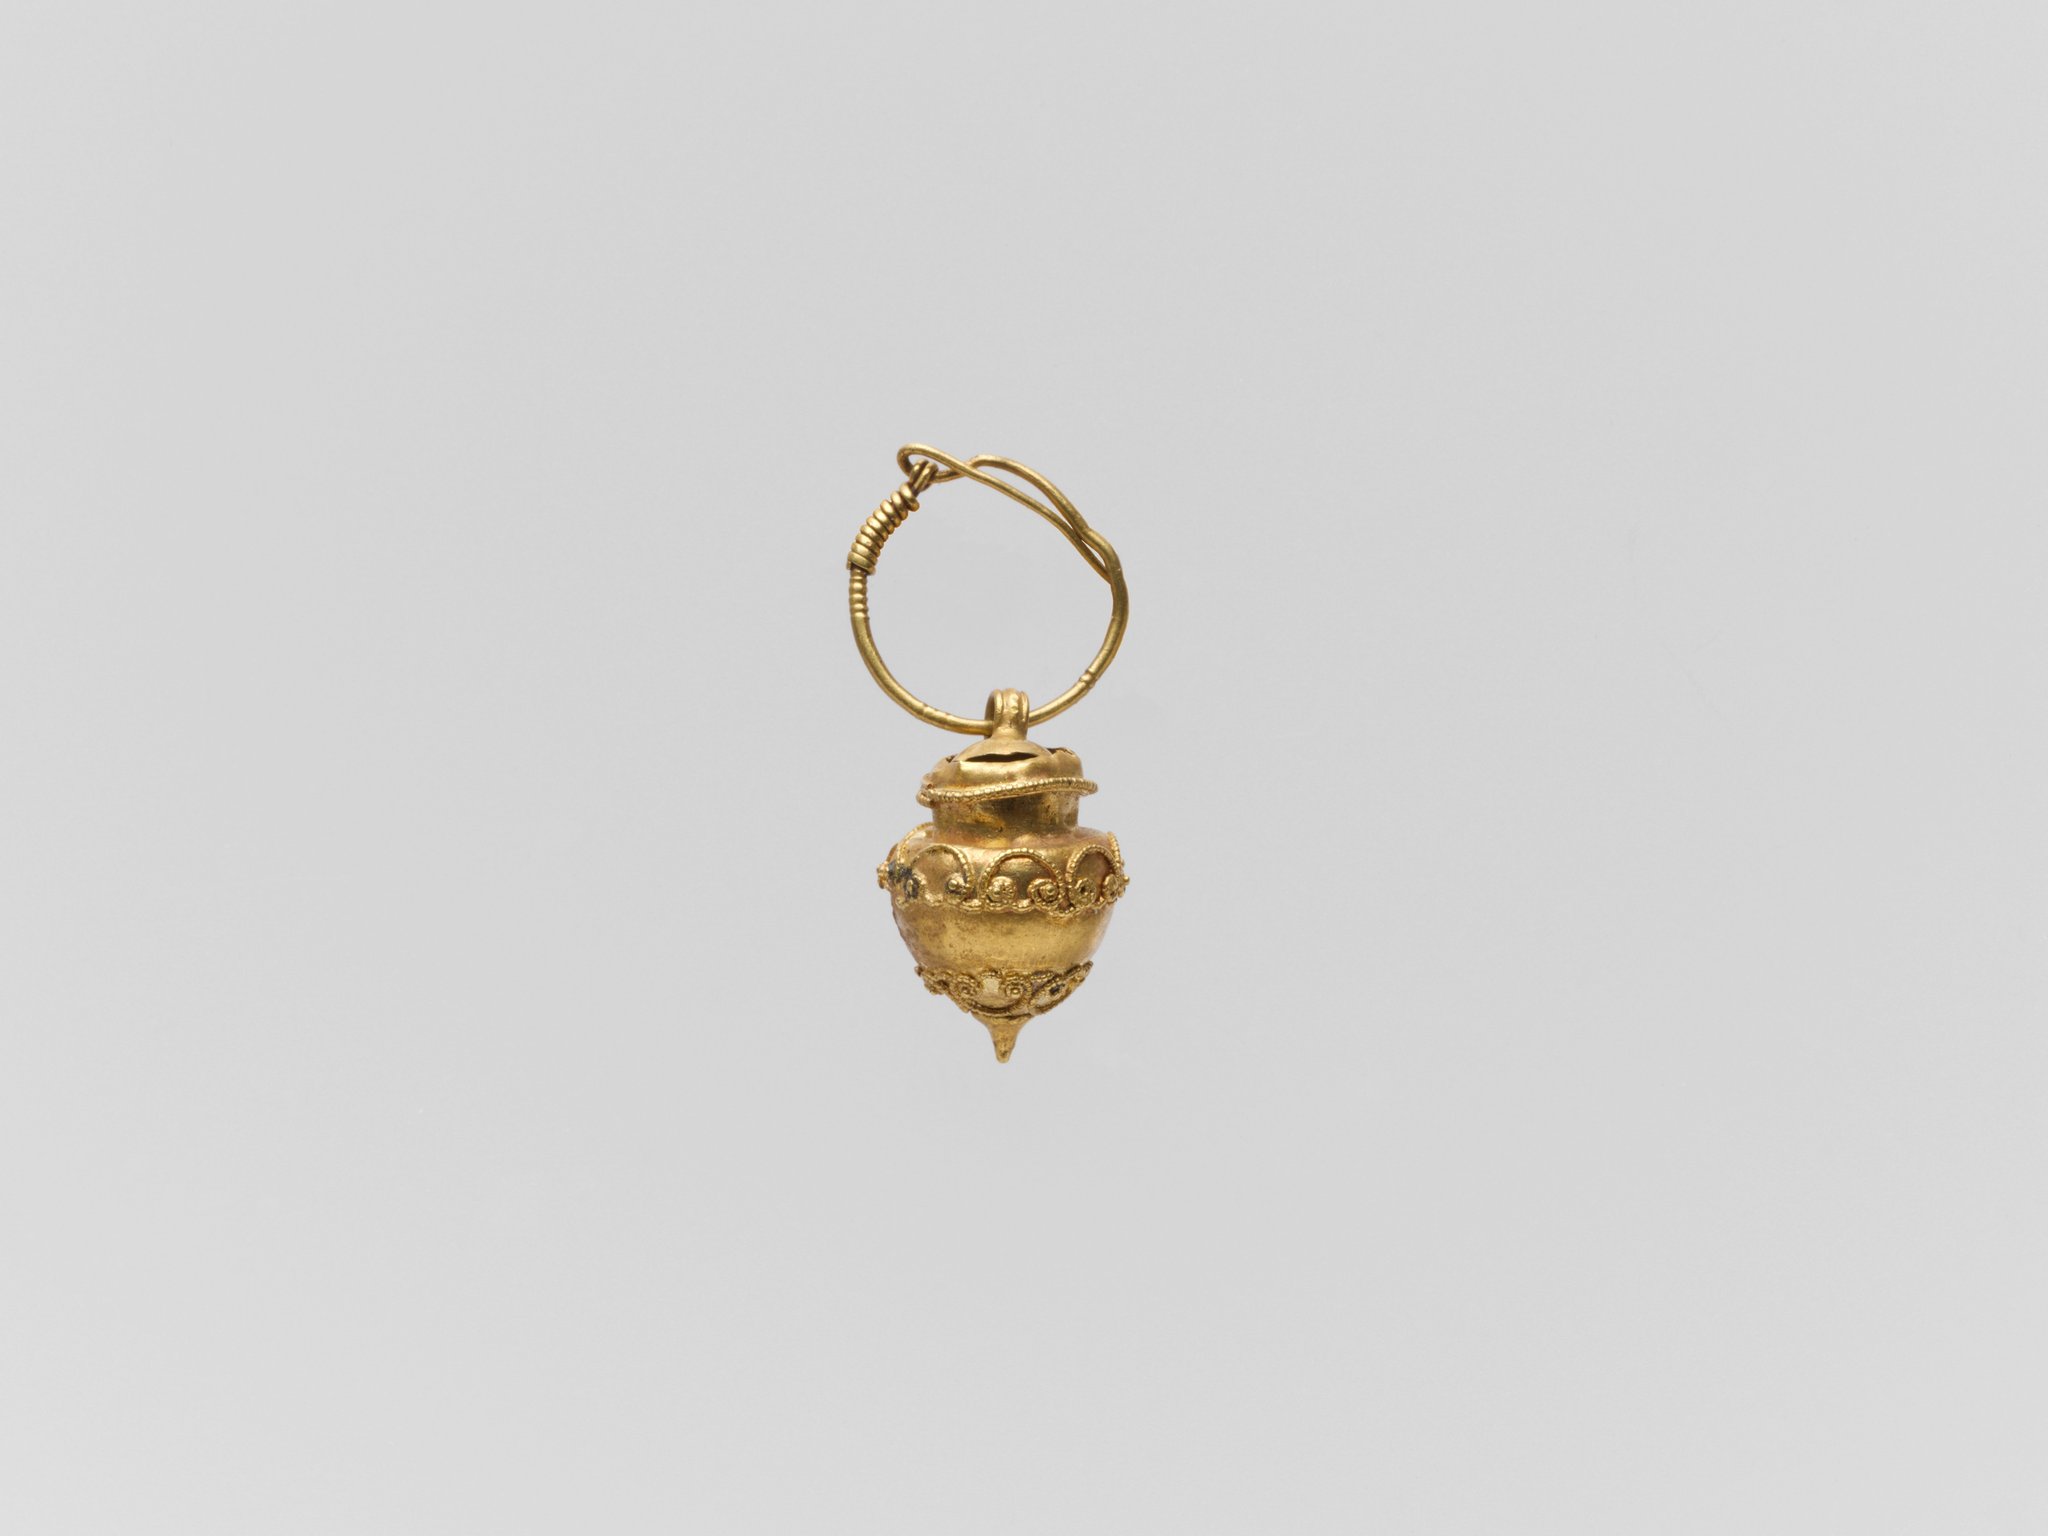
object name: pendant, vase shaped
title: Gold vase-shaped pendant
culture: cypriot or greek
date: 500-301 BCE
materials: gold